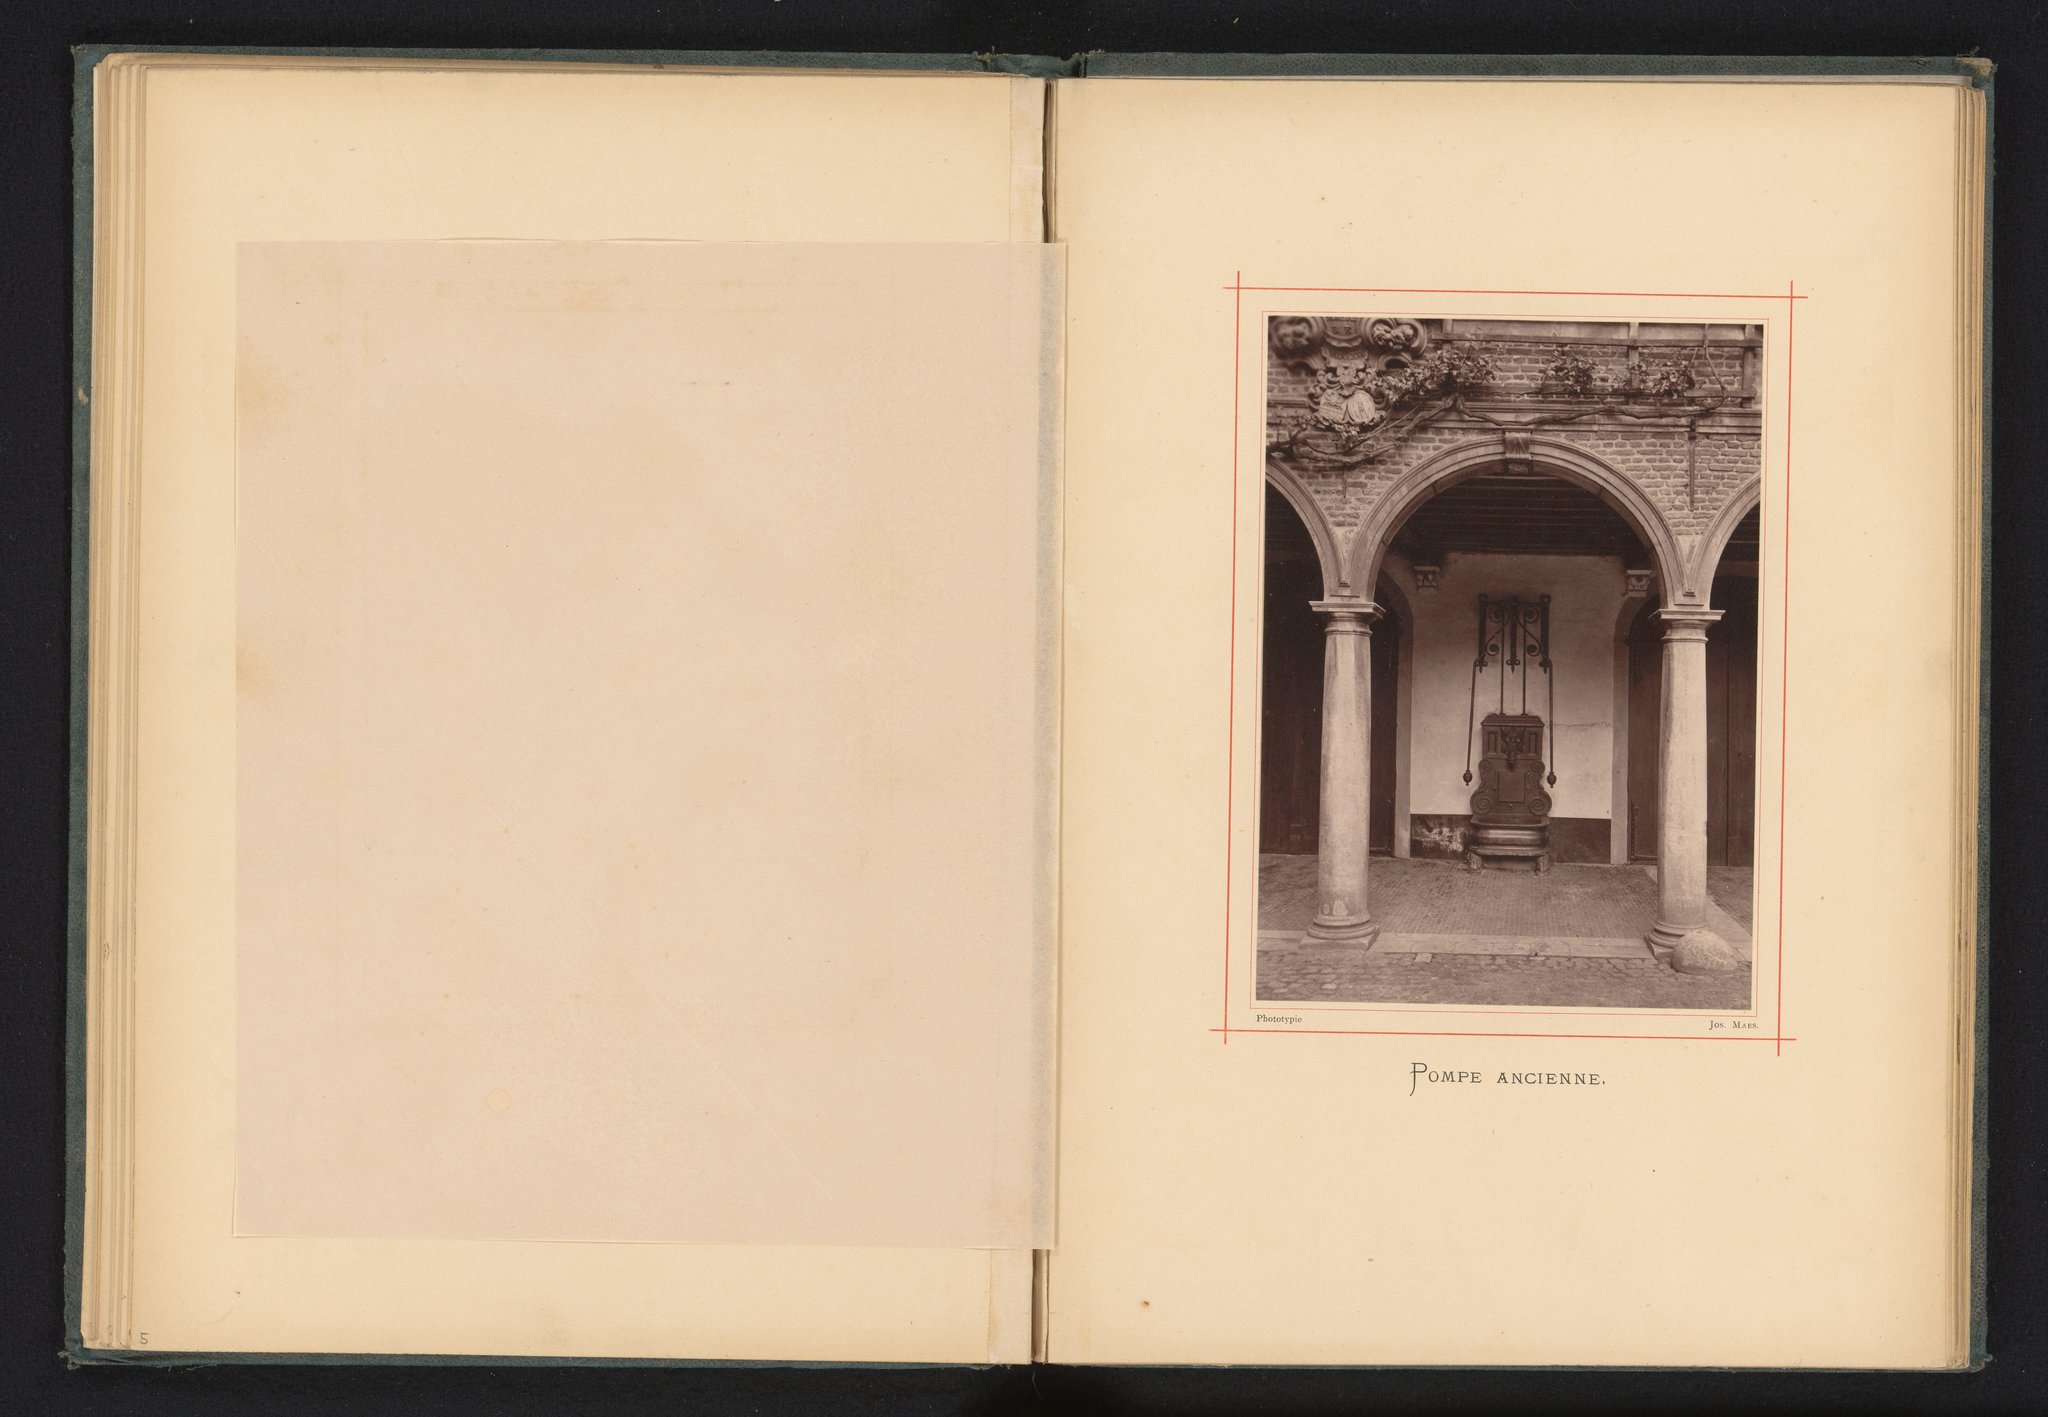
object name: photomechanical print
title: Pompe ancienne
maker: joseph maes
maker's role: fotograaf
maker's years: 1838-1908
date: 1873-1878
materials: paper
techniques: woodburytype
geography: antwerp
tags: courtyard, ornamental fountain